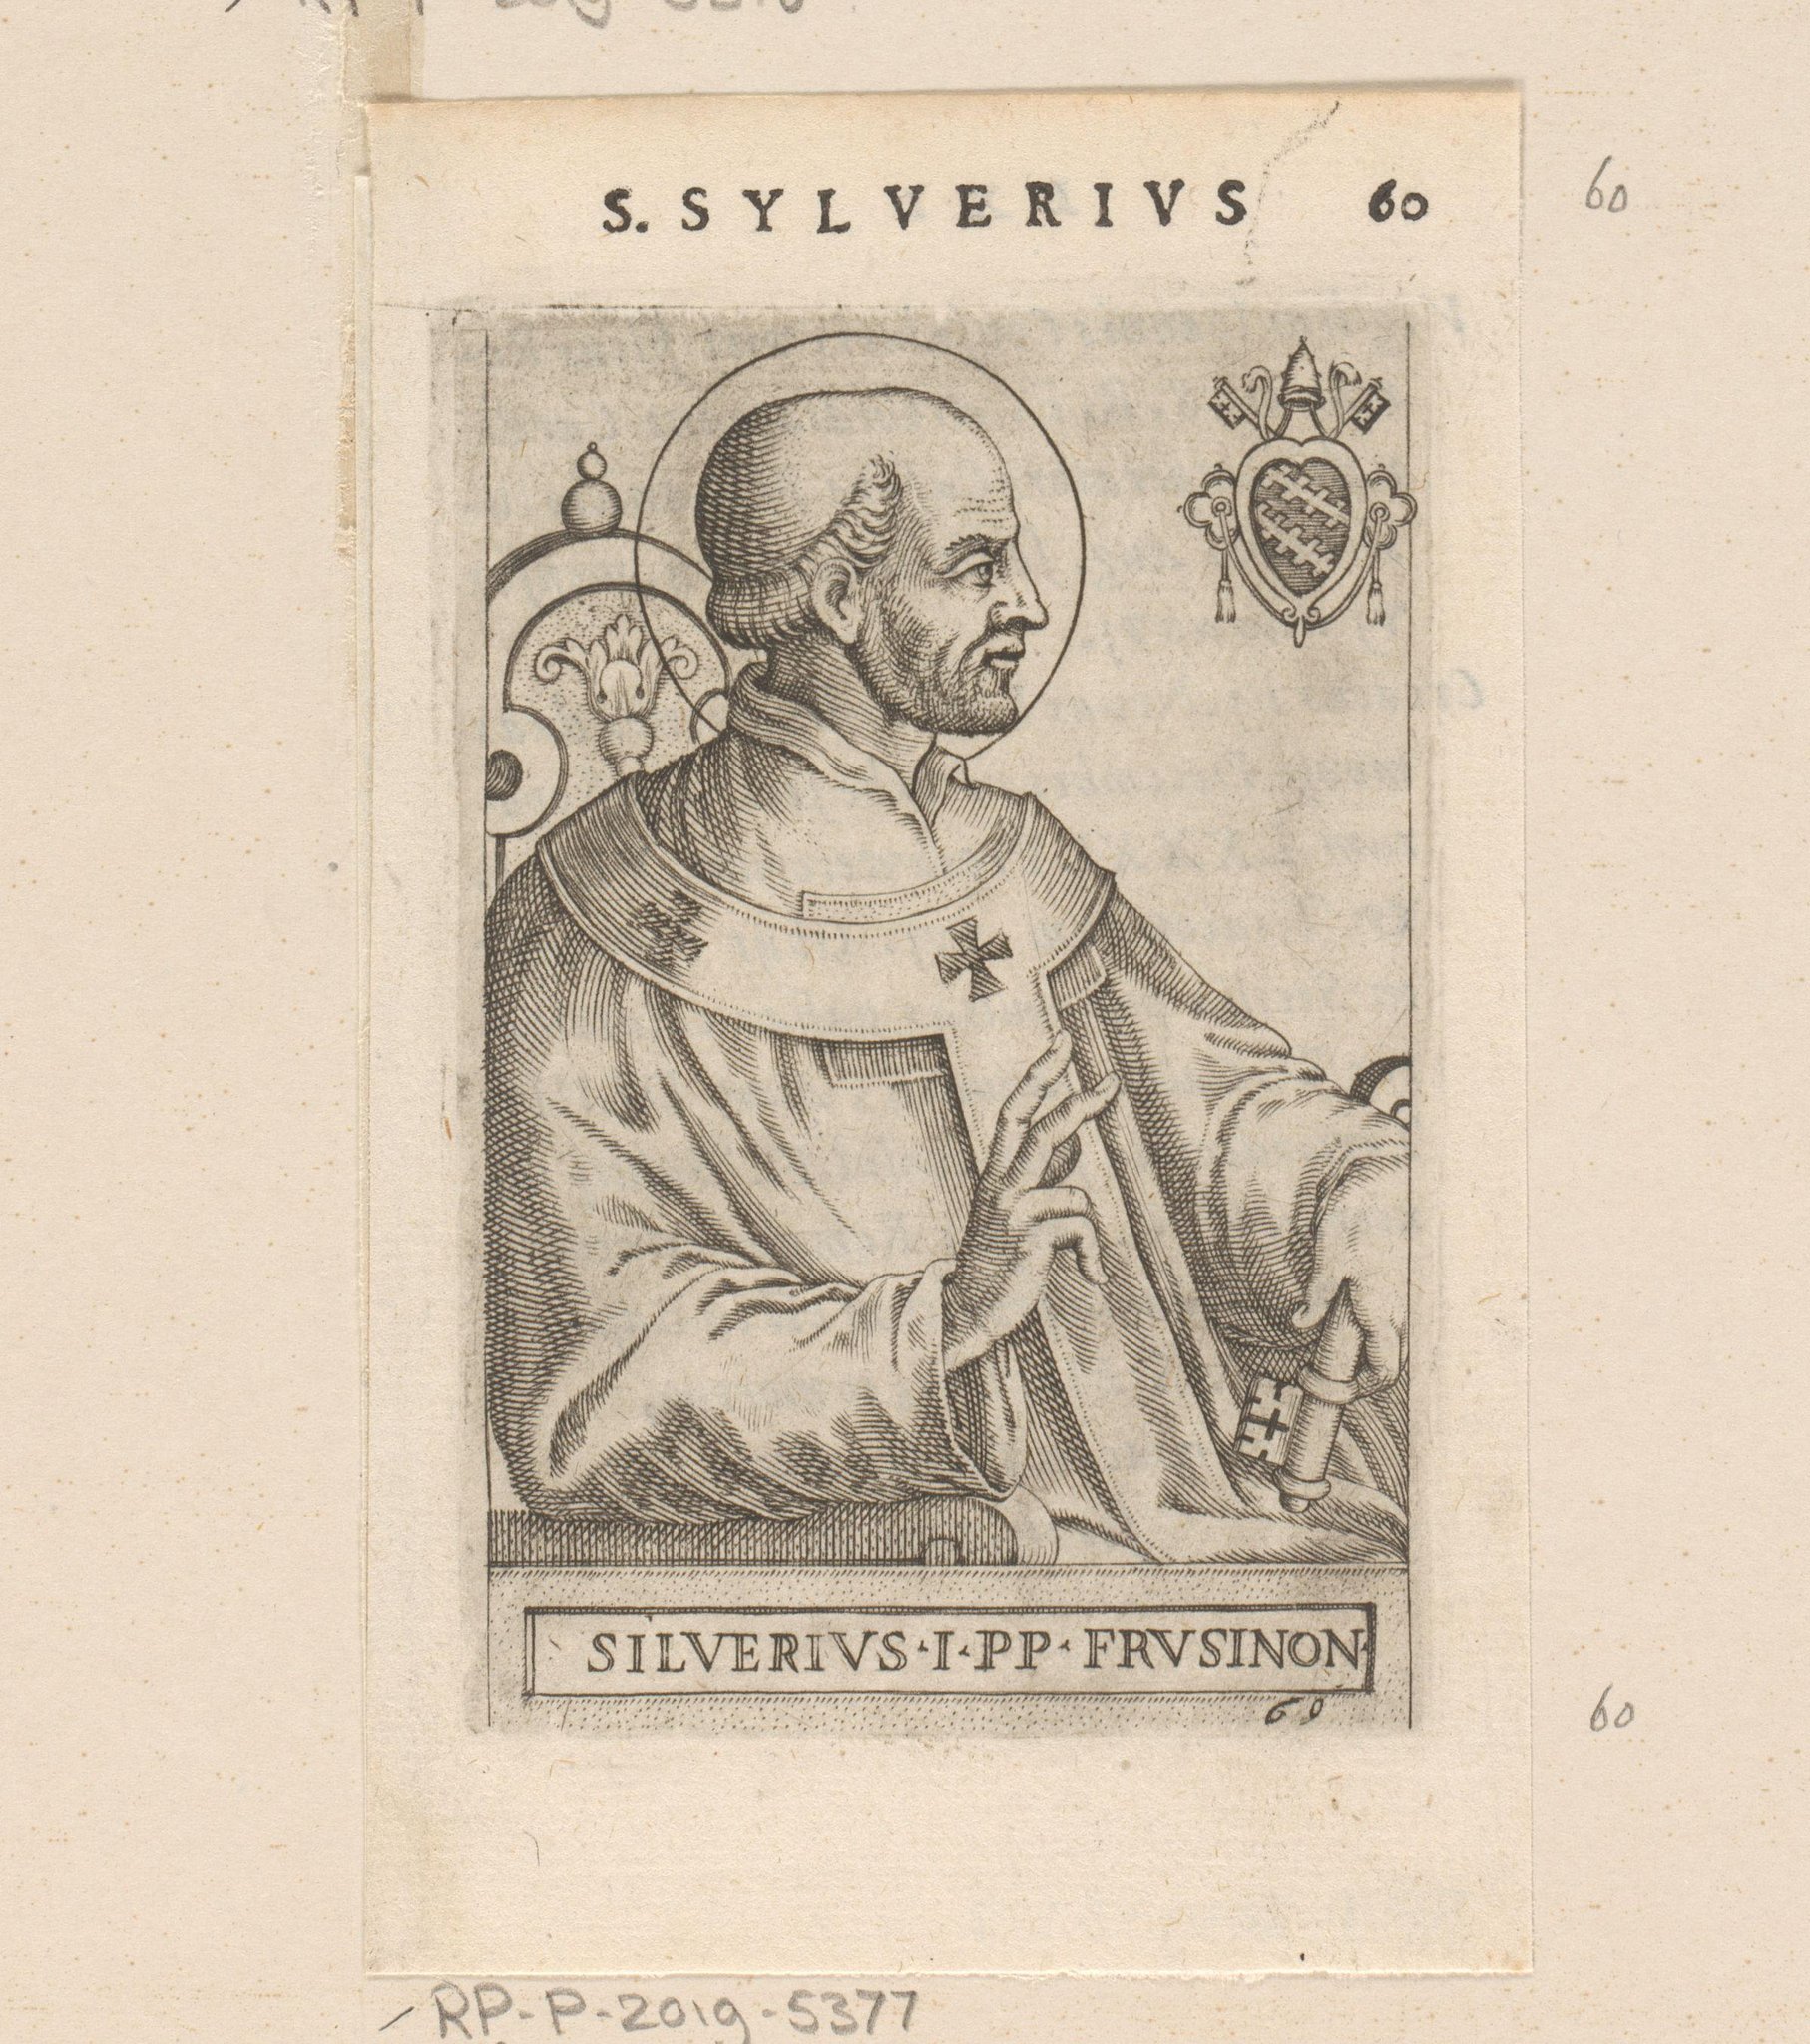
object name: book illustration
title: Portret van paus Silverius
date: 1595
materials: paper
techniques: engraving, letterpress printing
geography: rome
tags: historical persons, pope, armorial bearing, heraldry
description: Prent uit: Cavalieri, Giovanni Battista de'. Effigies pontificum romanorum cum eorum vitis (...). Rome: Bartolomeo Bonfadino, 1595. Prent voor het eerst verschenen in: Cavalieri, Giovanni Battista de'. Pontificum romanorum effigies (...). Rome: Domenico Basa en Francesco Zanetti, 1580. Prent ook gebruikt in latere publicaties.